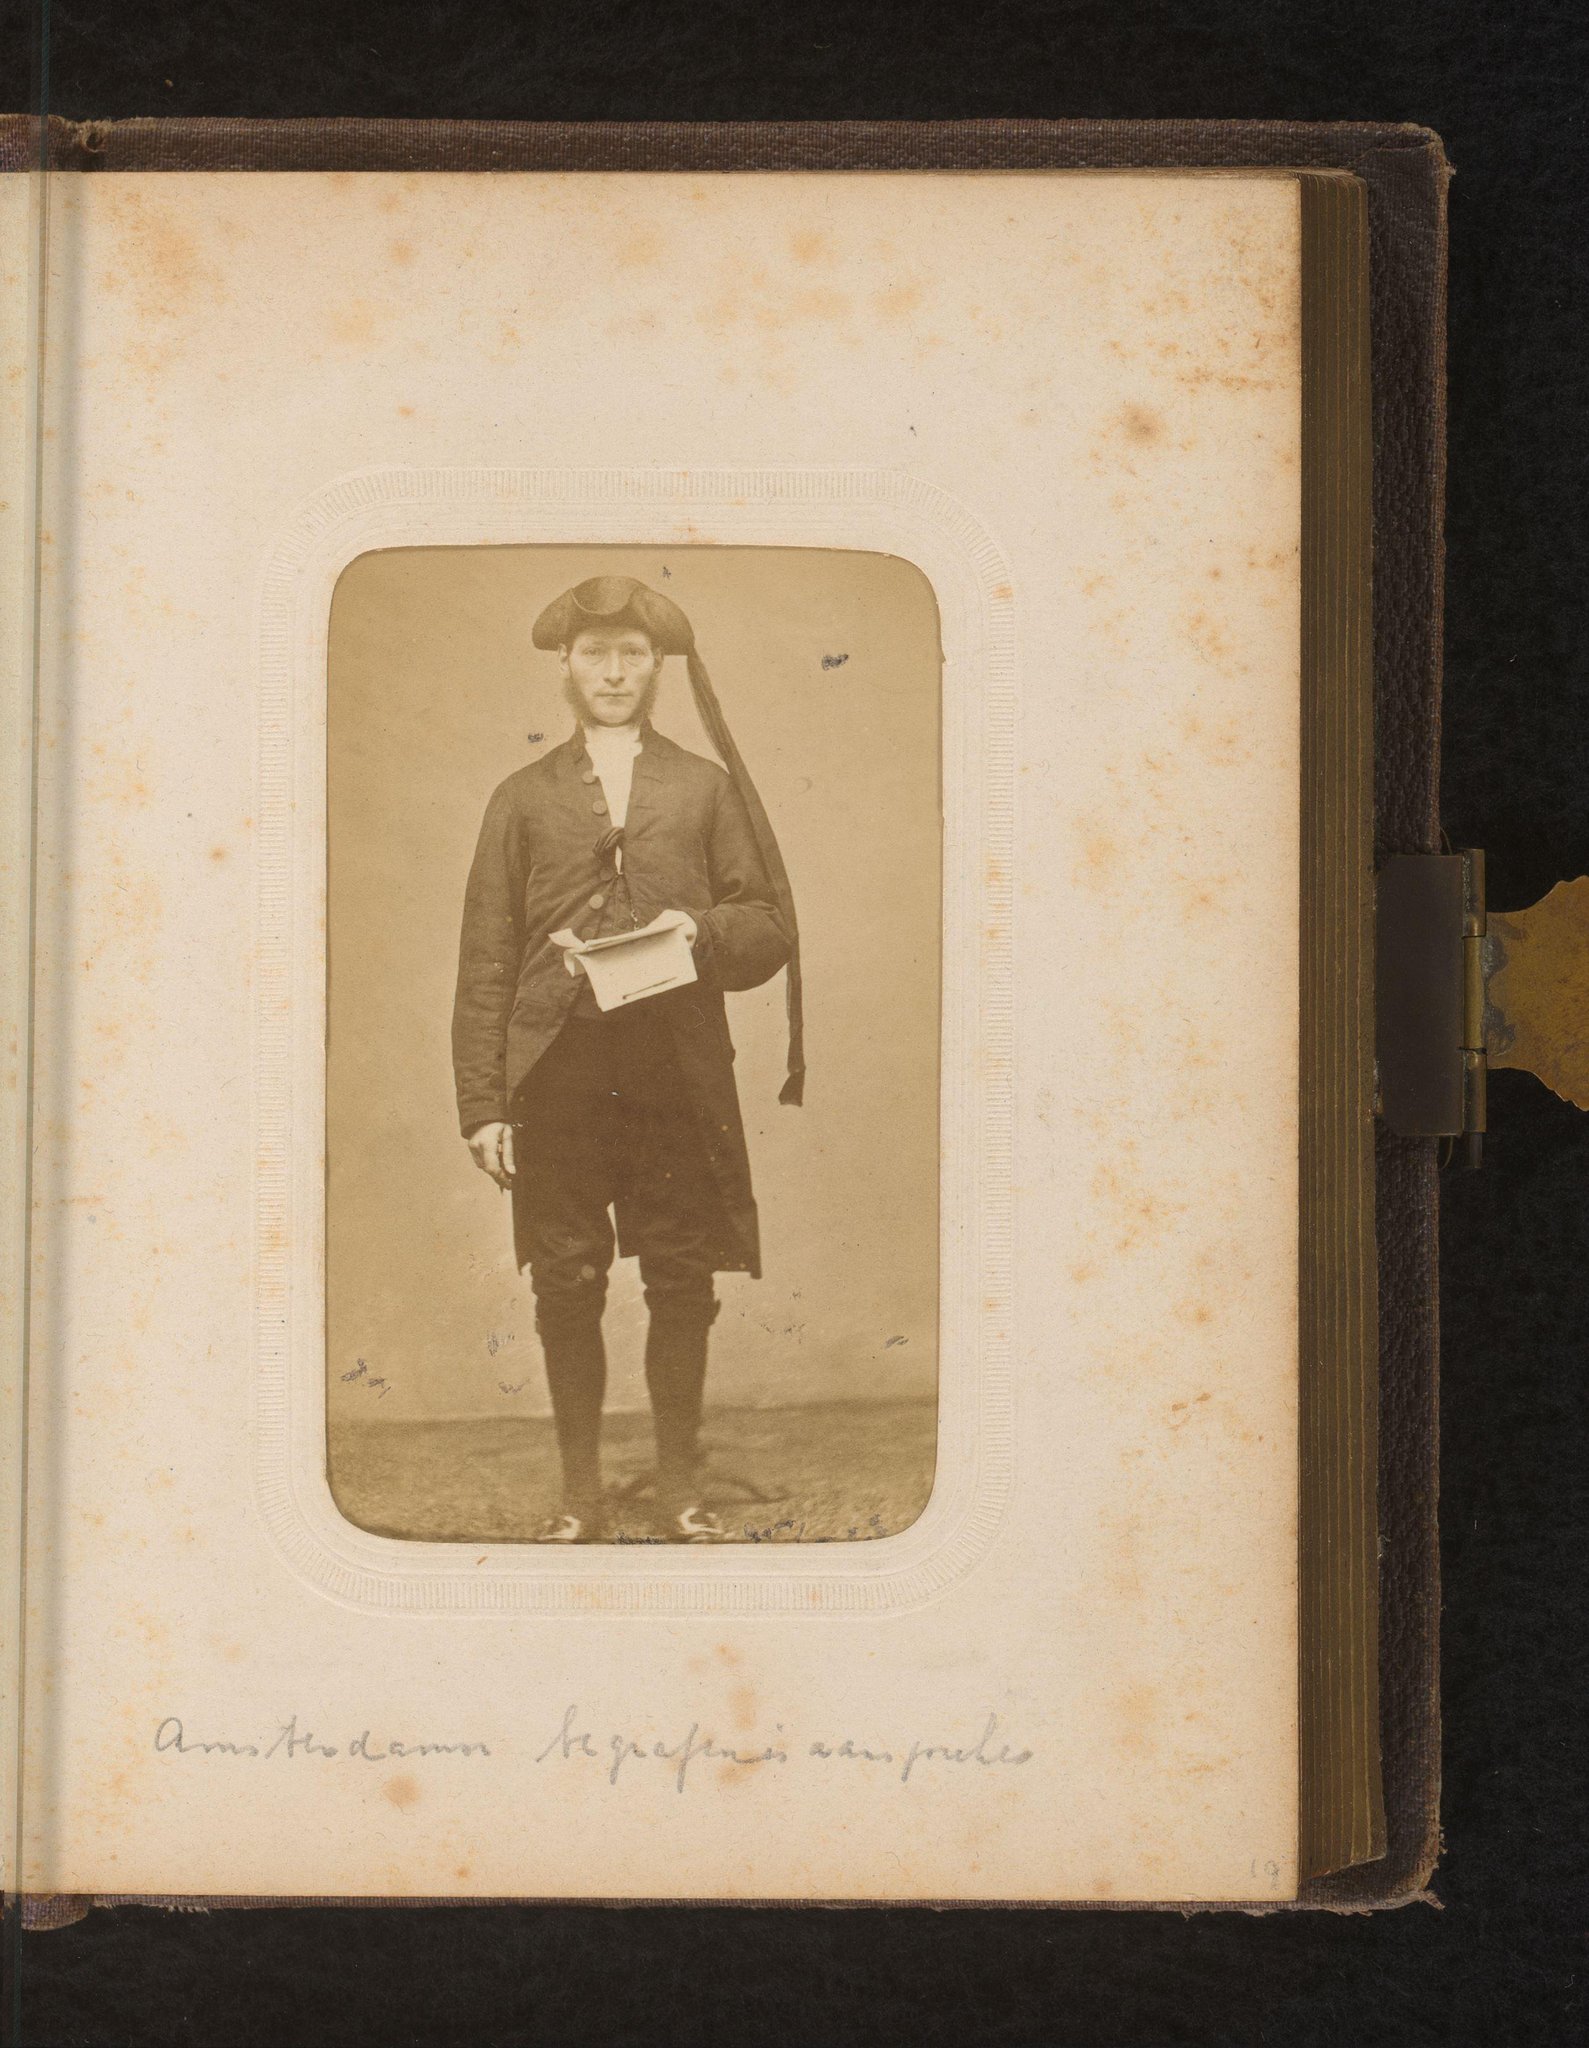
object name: album leaf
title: Portret van een aanspreker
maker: leonard ten hagen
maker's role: fotograaf, graveur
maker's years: 1838-1876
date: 1860-1900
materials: cardboard, photographic support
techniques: albumen print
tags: oral announcement (of death), undertaker's man, adult man, historical persons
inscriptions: annotation: ‘Amsterdam begrafenisaanspreker’, inscription: ‘Leonard ten Hagen/ Rozengracht/ Bij de Prinsengracht E.E.G./ Amsterdam’